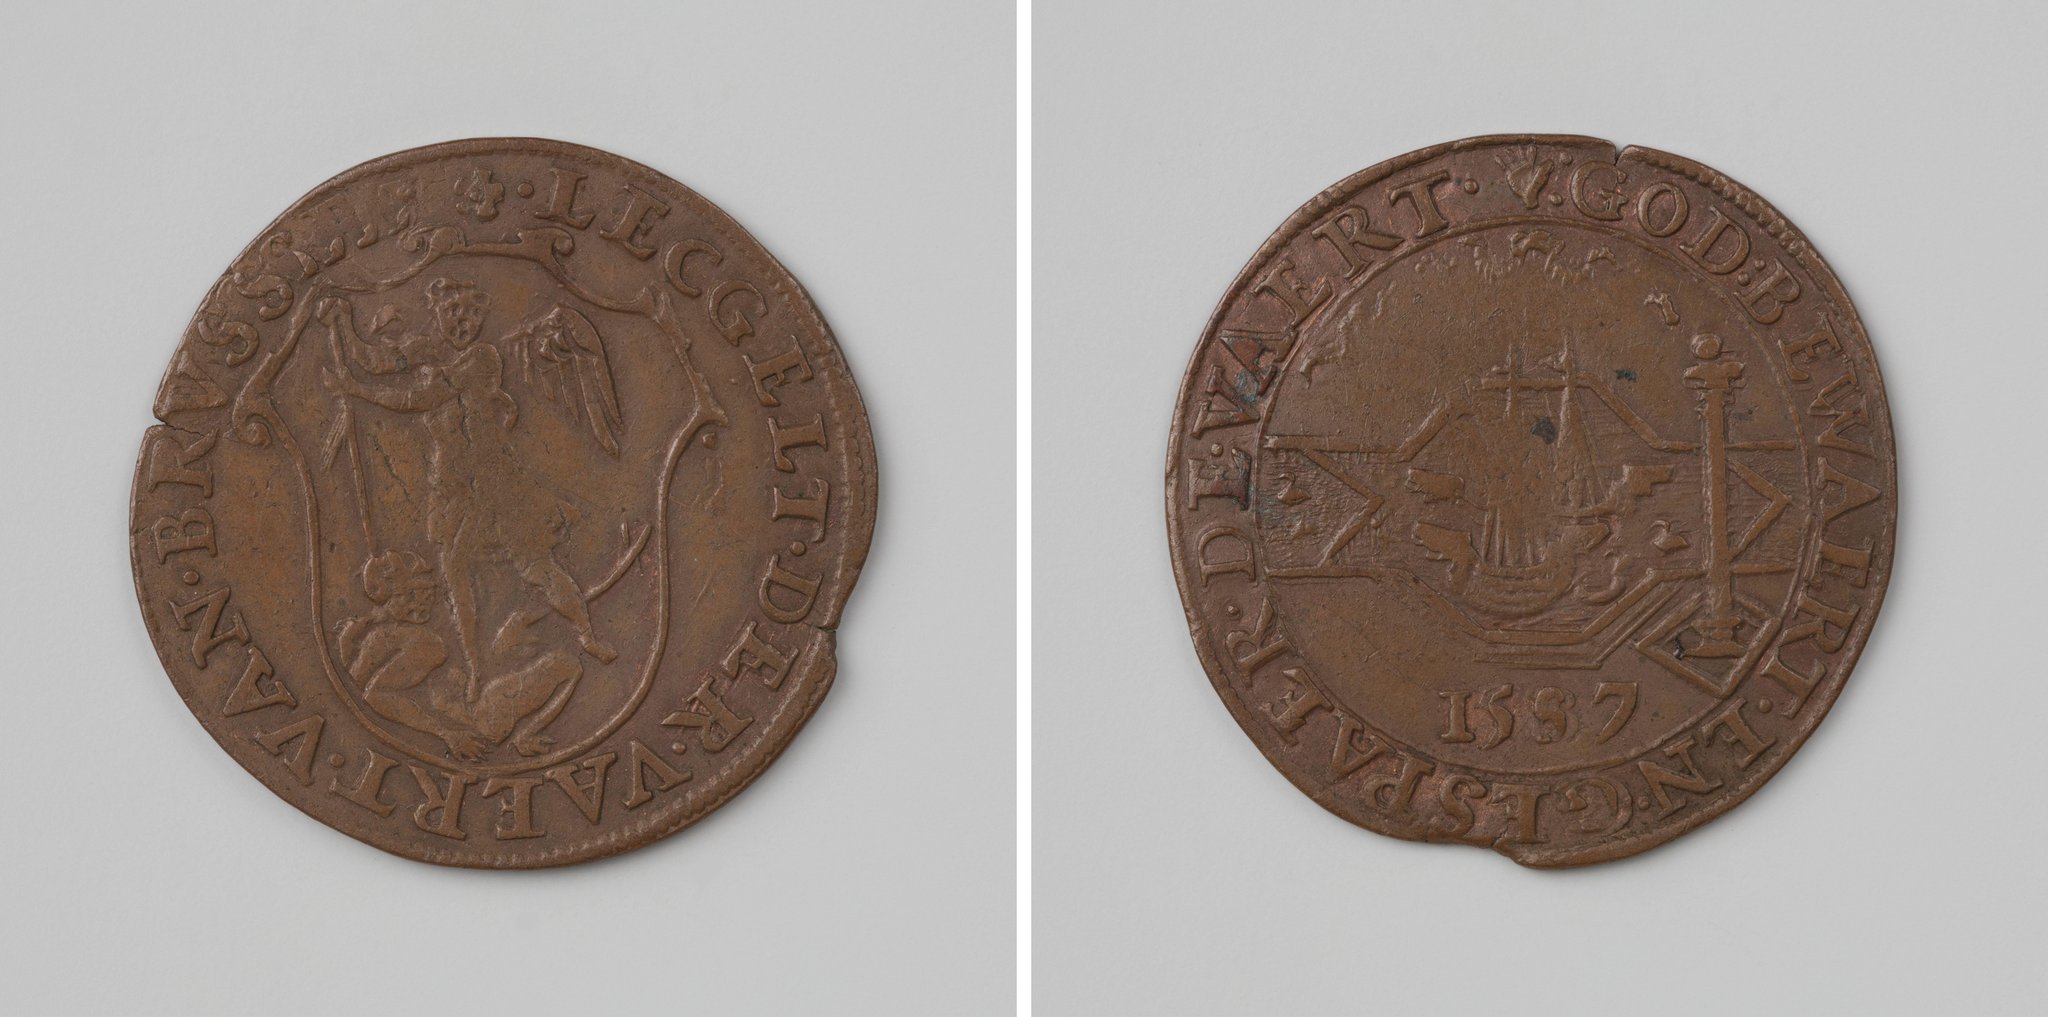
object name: jeton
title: Vaart van Brussel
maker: Anonymous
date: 1587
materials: copper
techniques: striking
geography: antwerp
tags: willebroekse vaart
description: Koperen penning. Voorzijde: wapenschild binnen omschrift. Keerzijde: twee zeilschepen boven jaartal binnen omschrift